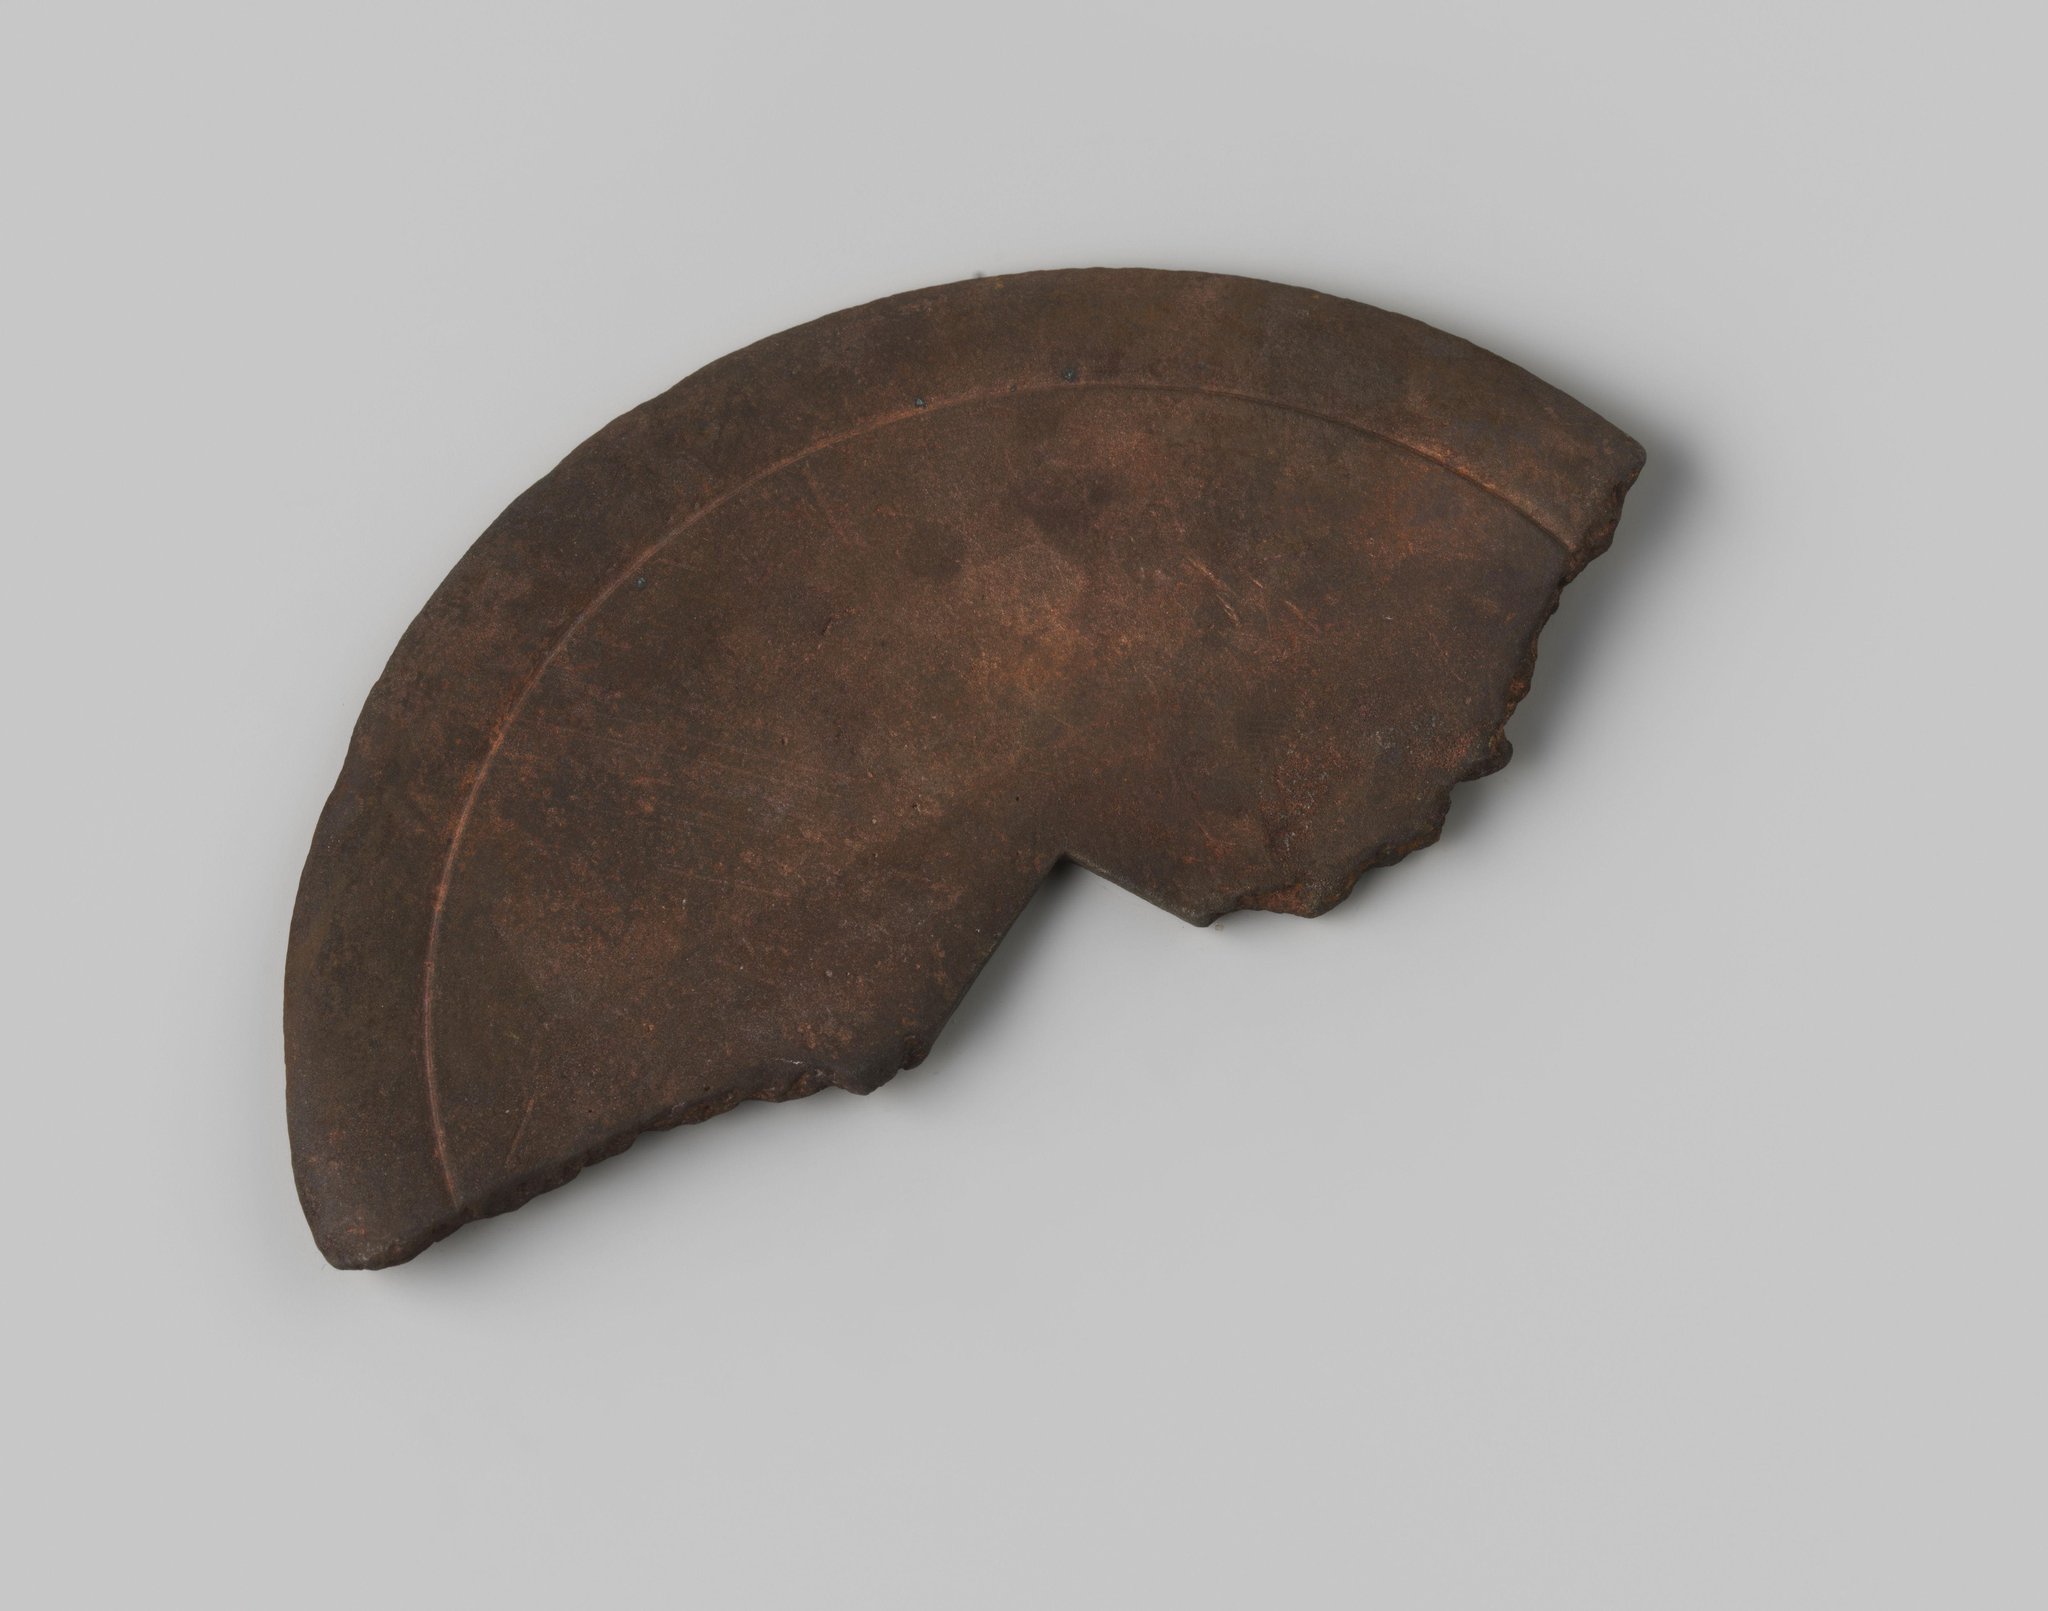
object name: bobeche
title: Fragment vetvanger uit het wrak van de Oost-Indiëvaarder Hollandia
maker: Anonymous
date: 1700-1743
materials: copper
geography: netherlands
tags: verenigde oostindische compagnie, hollandia (schip), annet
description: Candlestick, drip-pan; fragm of rim with central hole, id. NG 1980-27H867. Drip-pan.